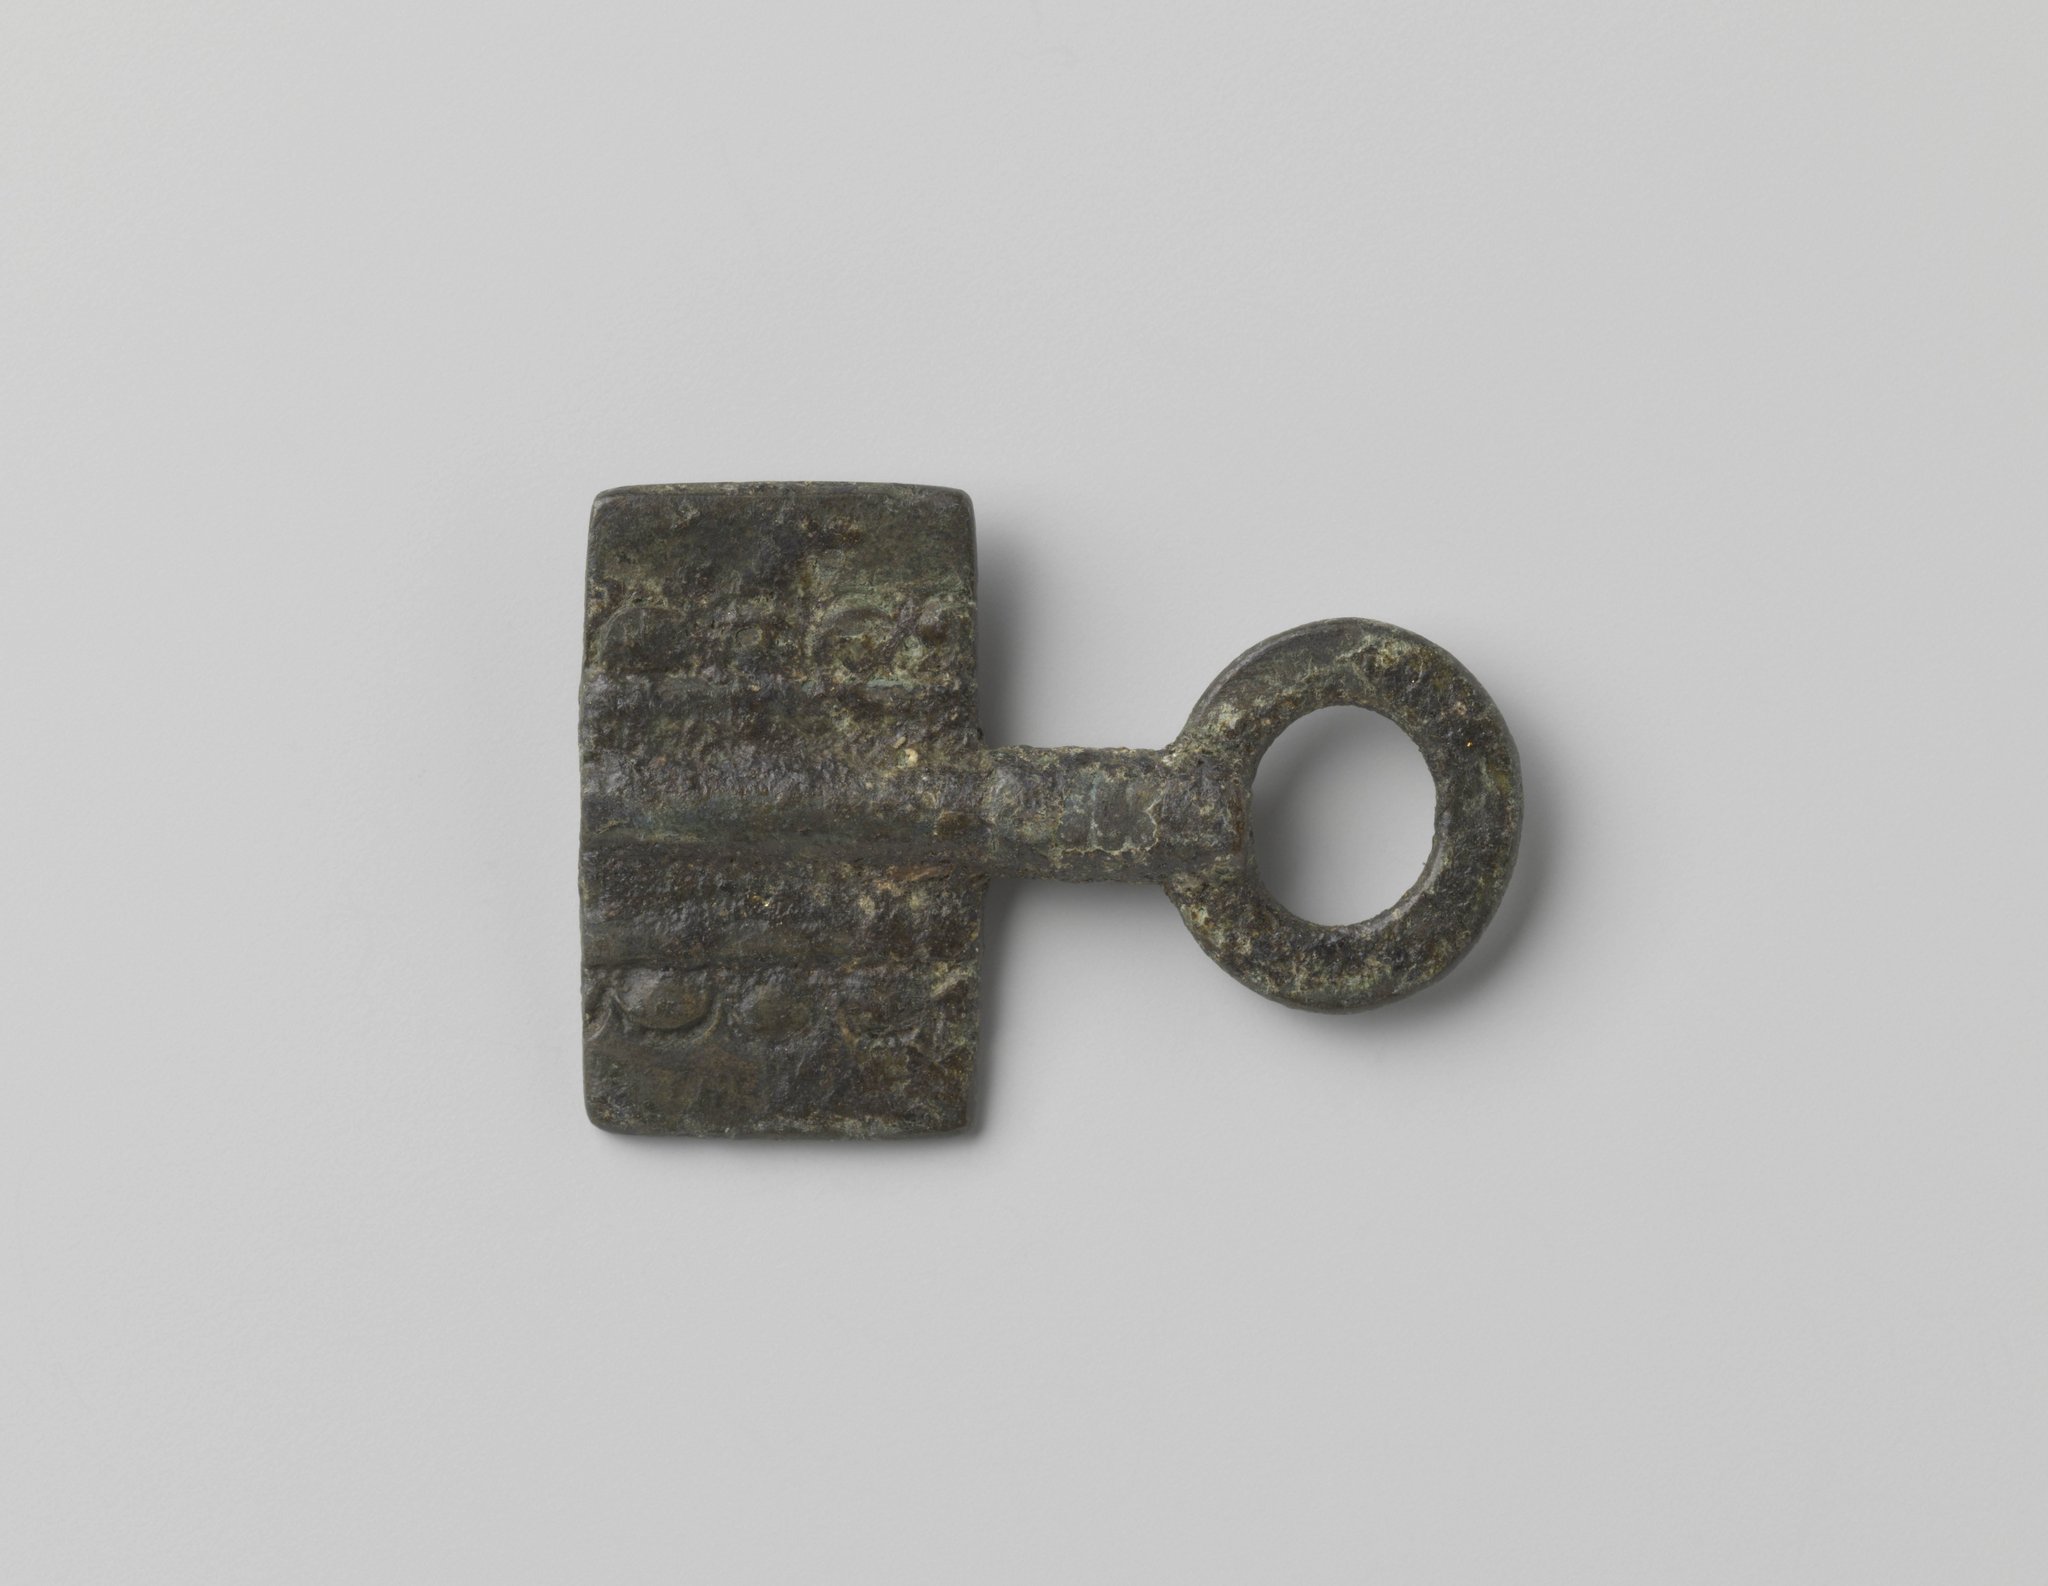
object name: pipe key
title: Pijpsleutel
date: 1400-1950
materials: bronze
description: Pijpsleutel met plat, ringvormig oog en een platte, vierhoekige baard aan weerszijden van de schacht.